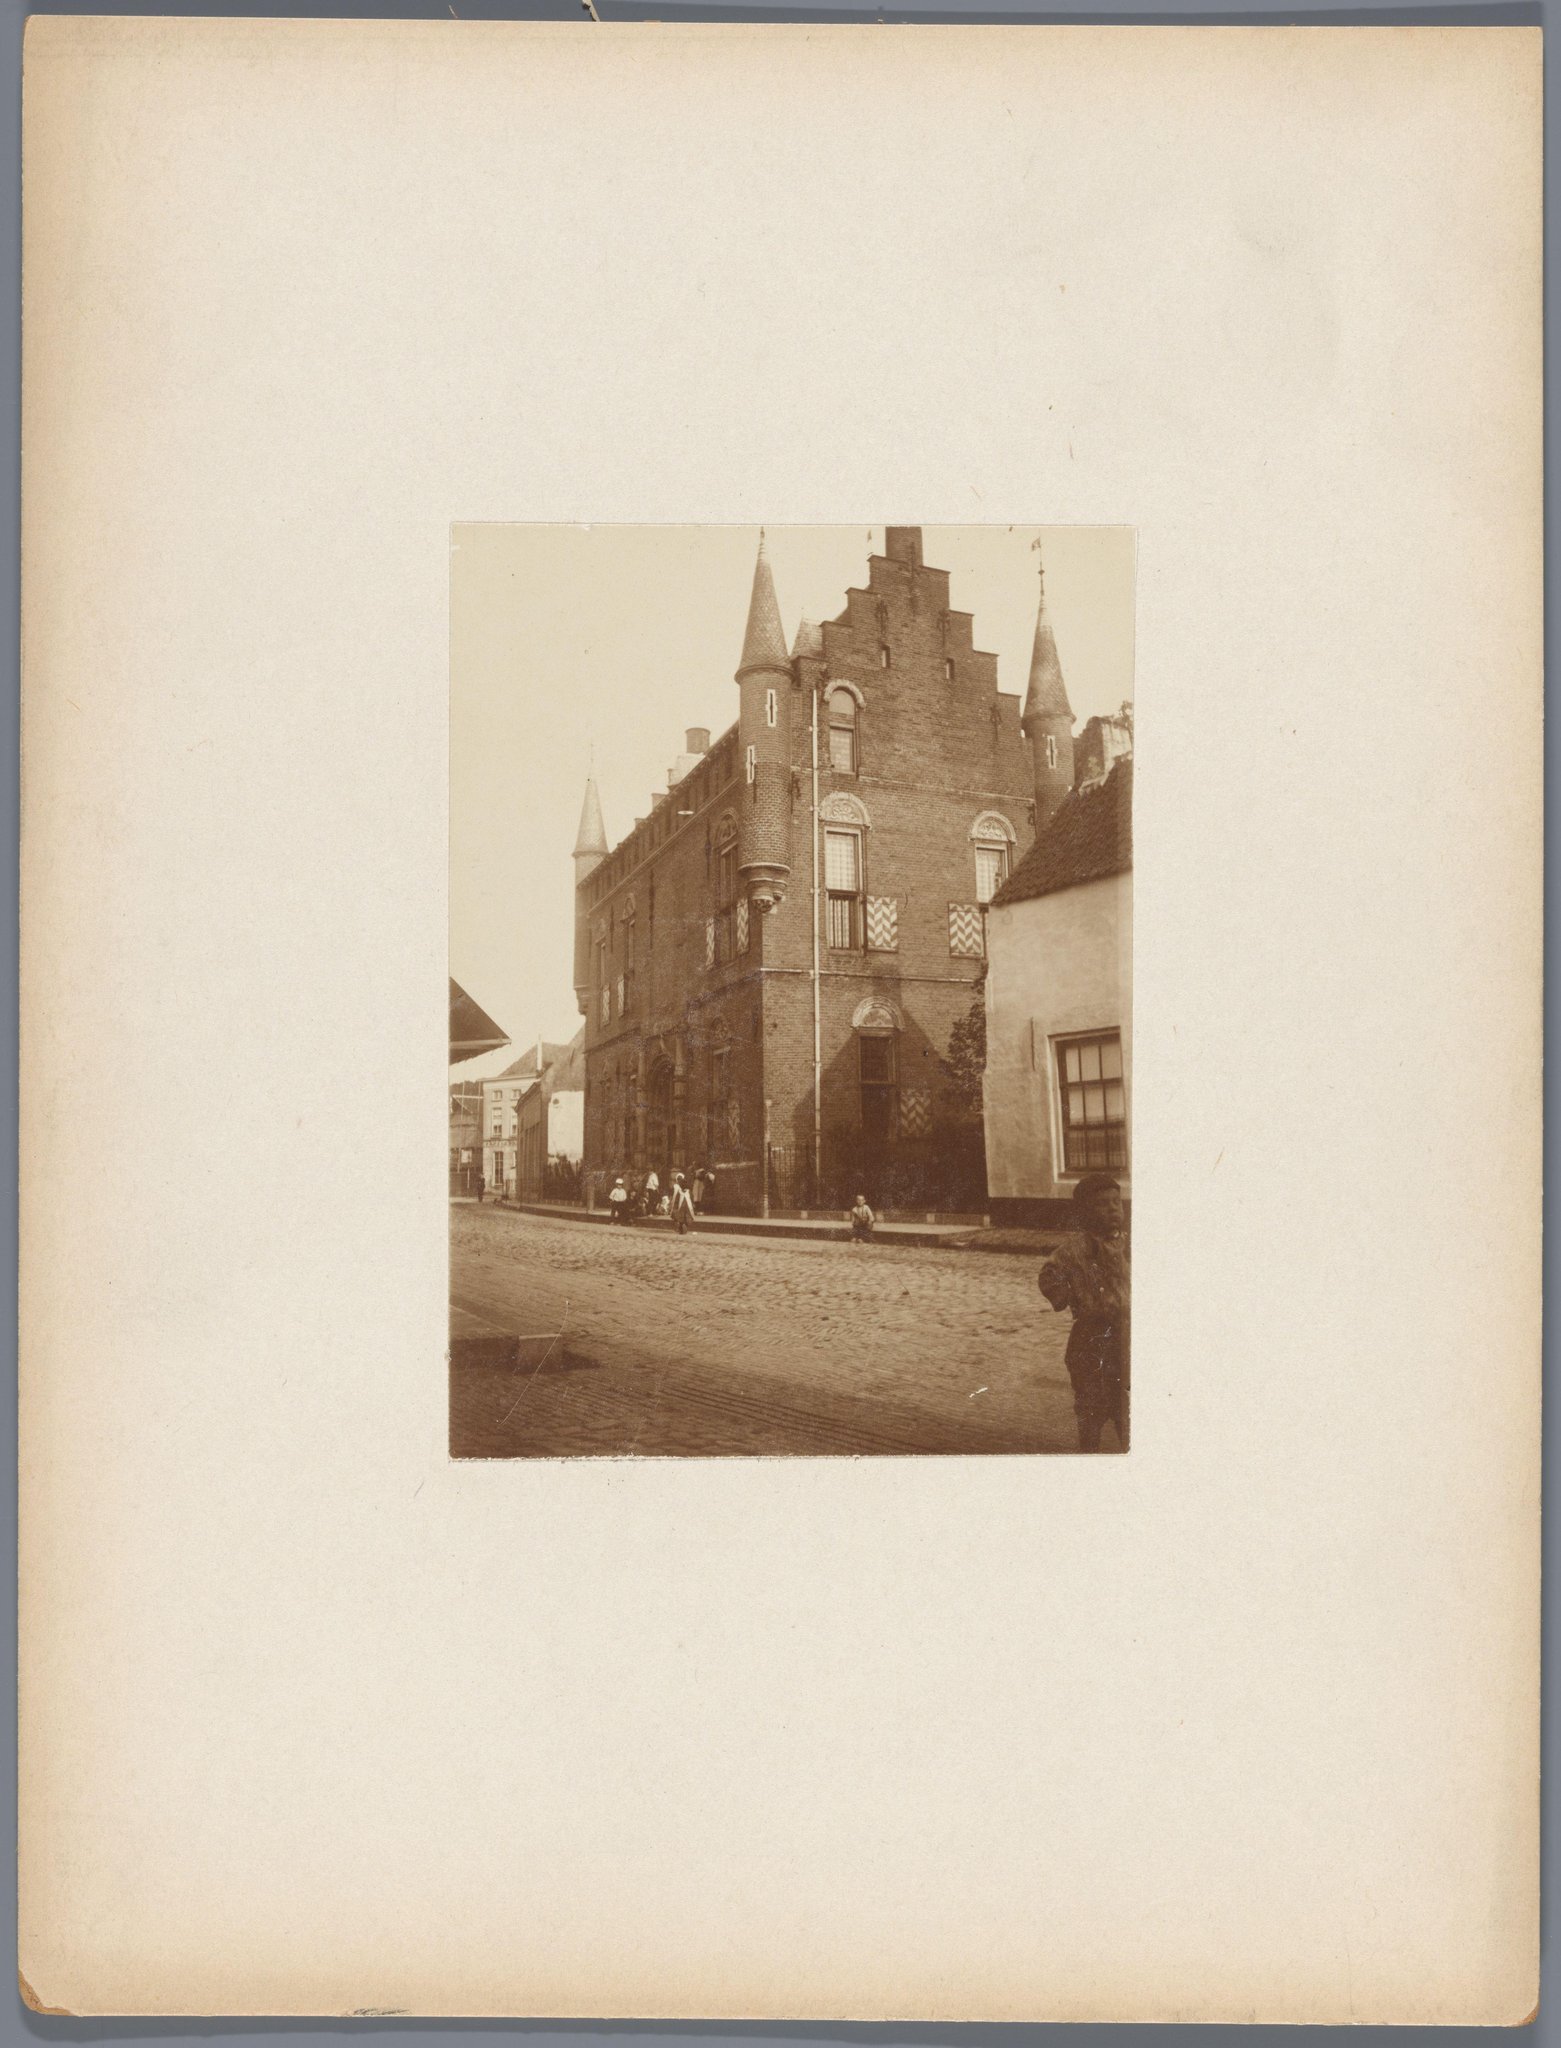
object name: photograph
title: Monumentaal gebouw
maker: Anonymous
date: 1907-1910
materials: cardboard, photographic support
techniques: collodion silver print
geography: netherlands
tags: street (+ city(-scape) with figures, staffage), netherlands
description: Monumentaal gebouw met trapgevel. Onderdeel van het losbladige fotoalbum met 39 foto's van een reis door Nederland, ca. 1907-1910.